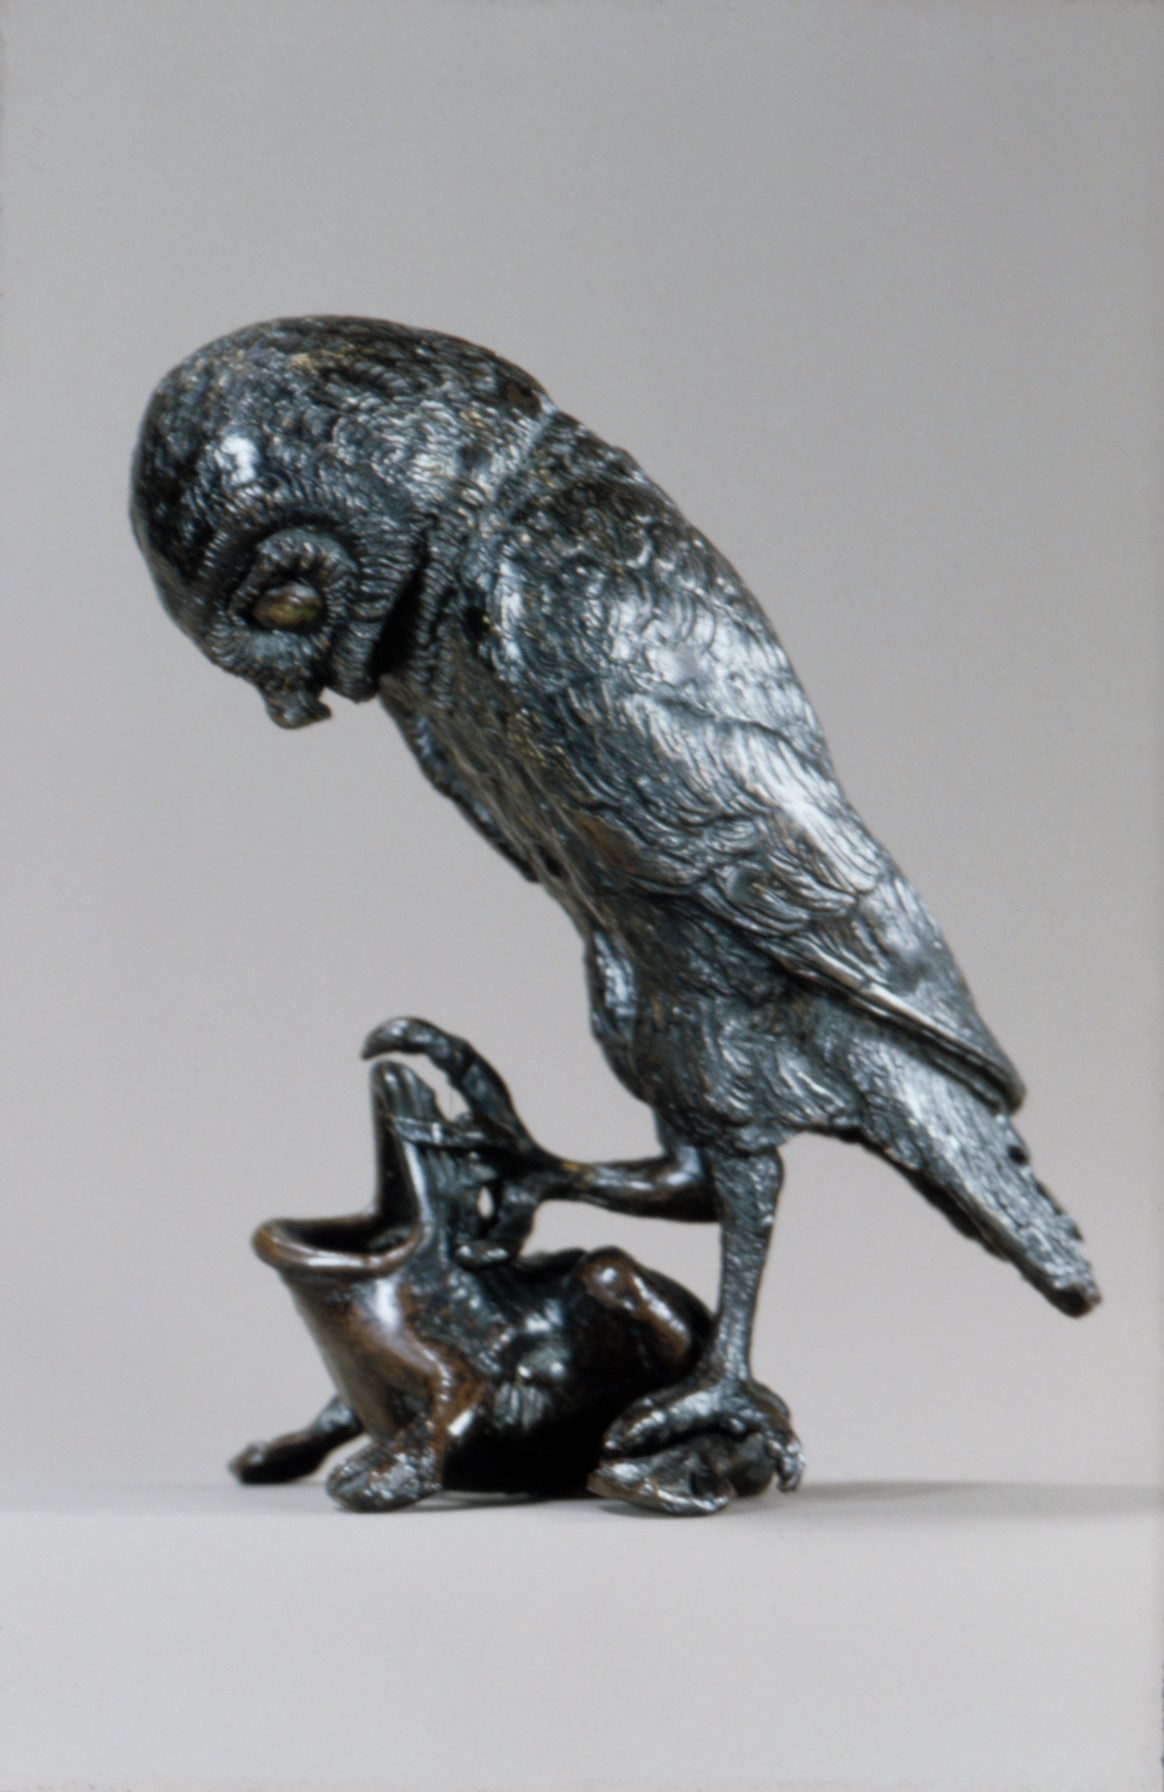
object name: statuette group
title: Owl on a Frog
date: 1620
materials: bronze, lacquer, patina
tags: owls,frogs